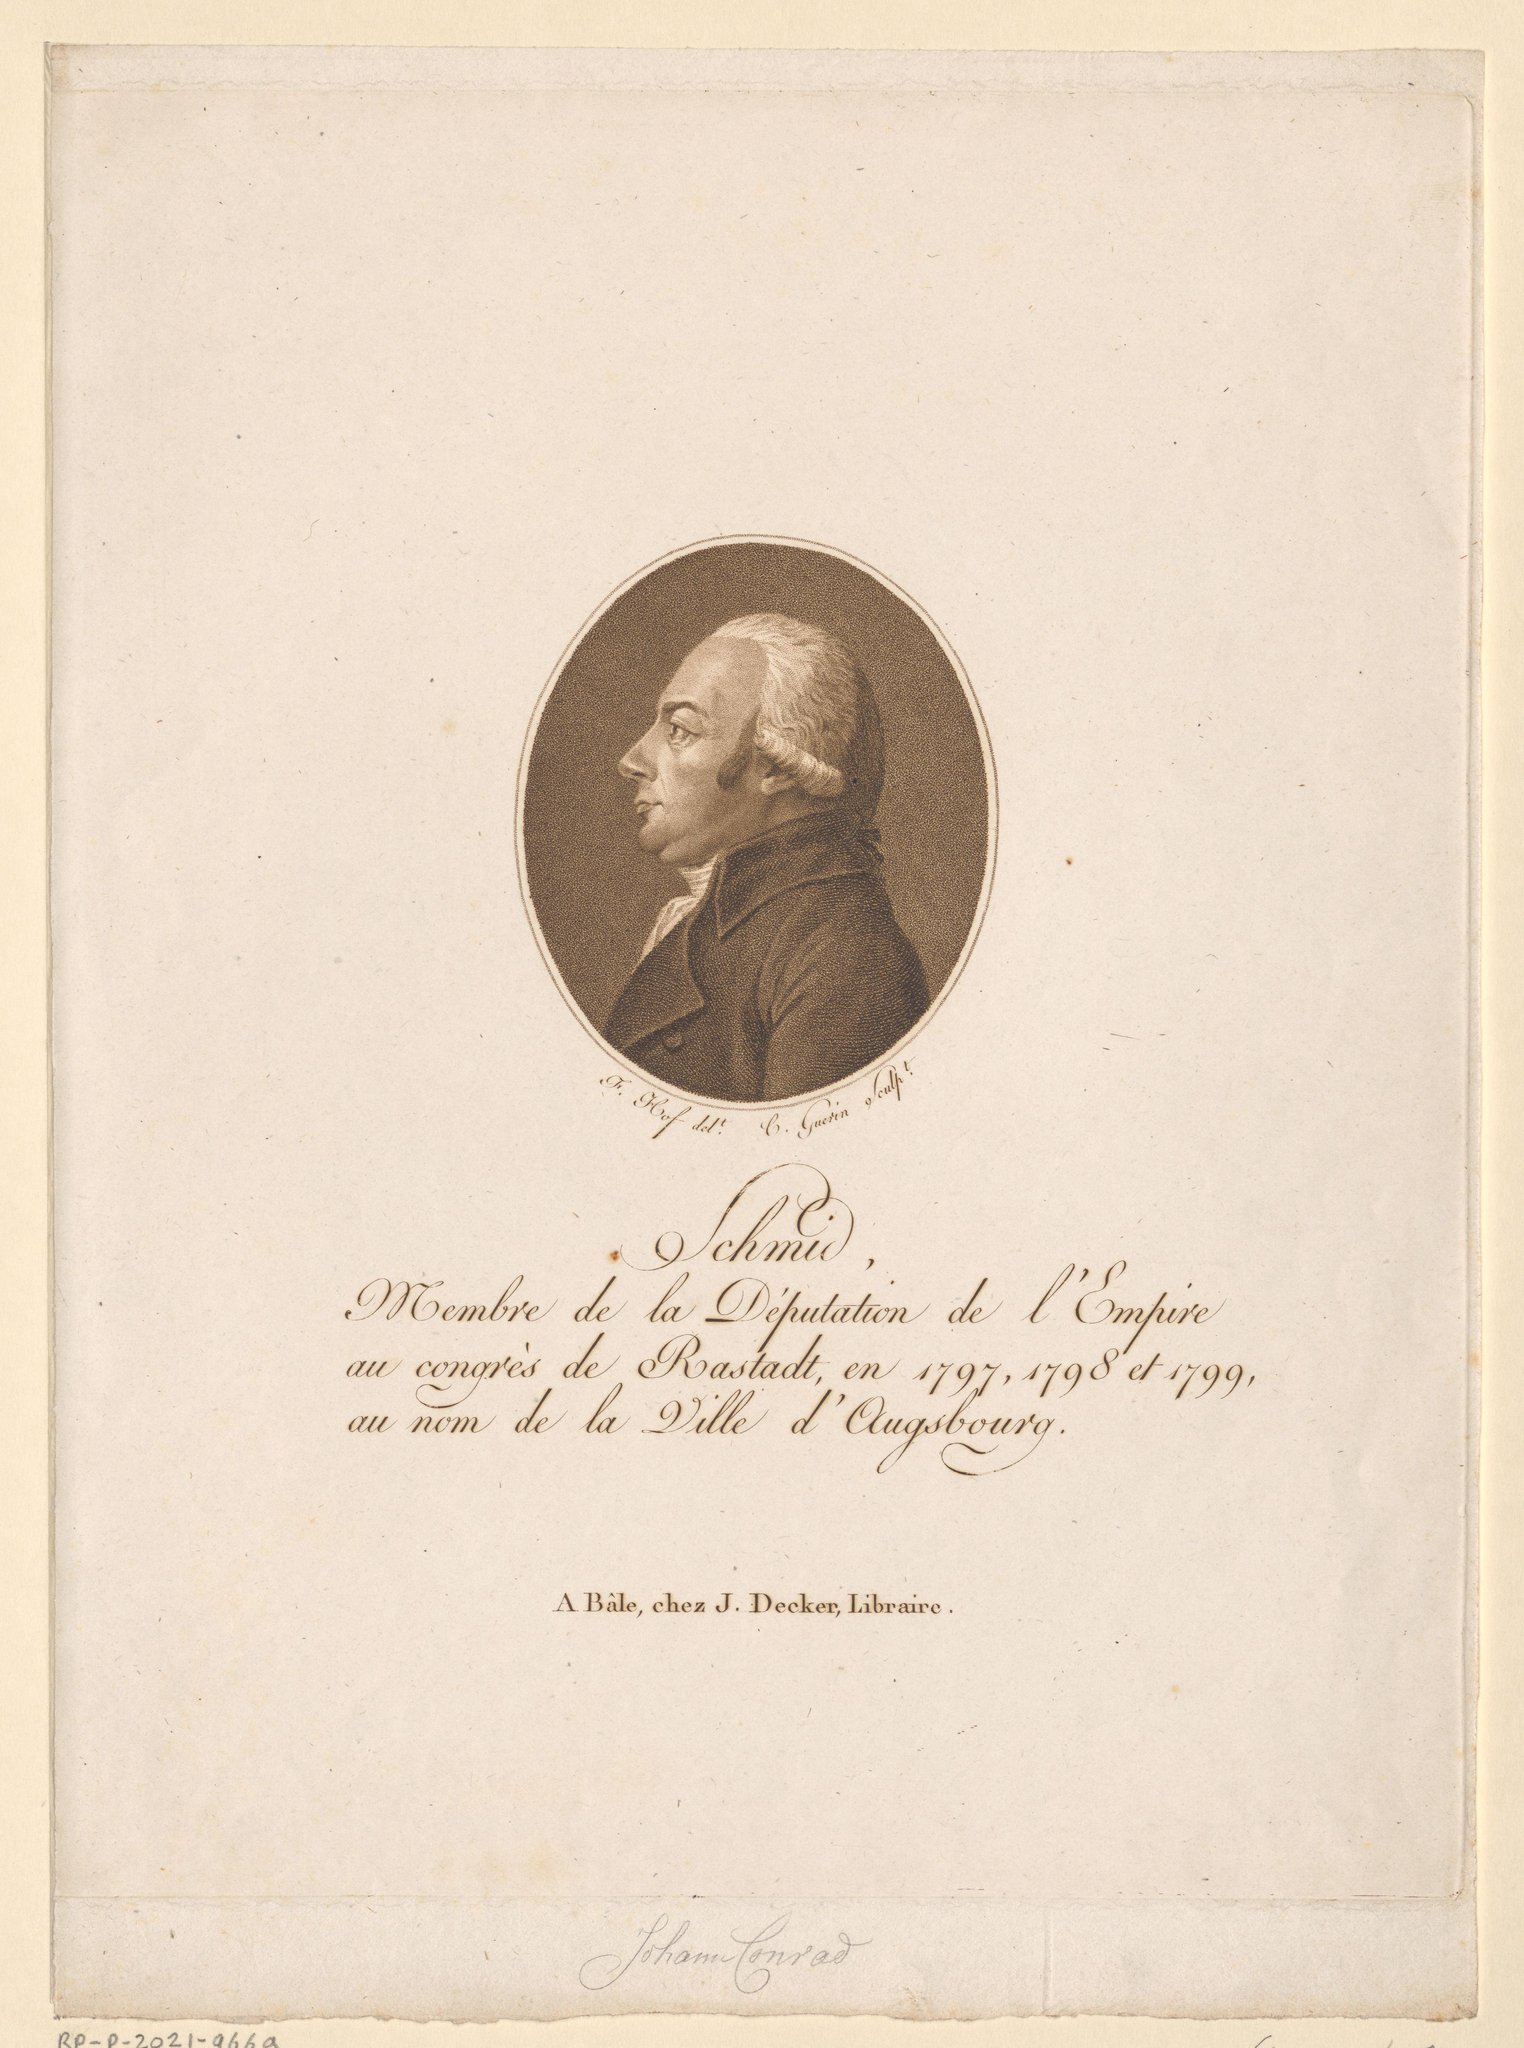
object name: print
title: Portret van Johann Konrad Schmid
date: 1799-1831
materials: paper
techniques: engraving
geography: basel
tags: historical persons, diplomacy, diplomat